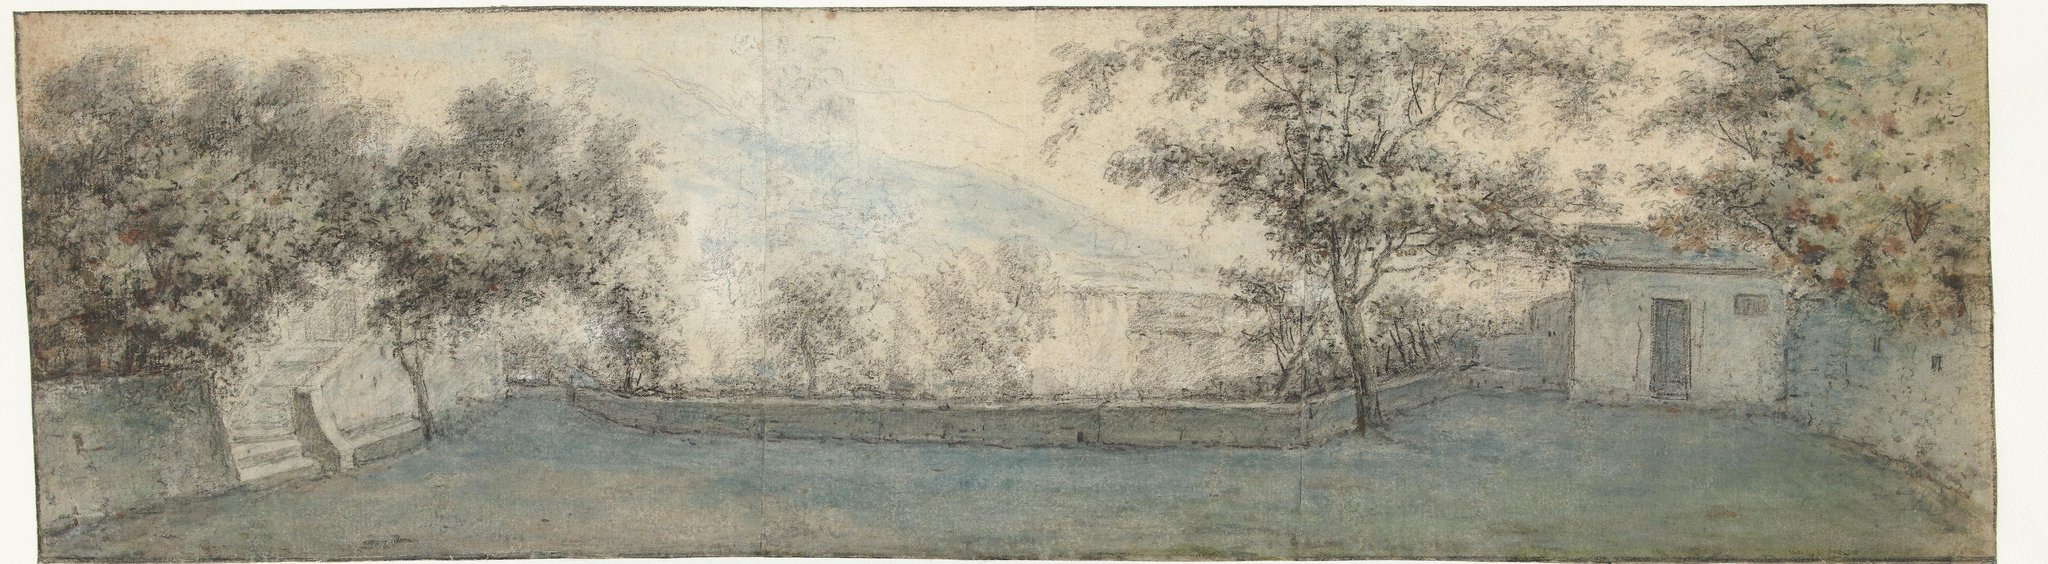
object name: drawing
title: Gezicht op een terras met links en rechts een paviljoen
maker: pierre adrien pâris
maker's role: draughtsman, print maker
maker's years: 1745-1819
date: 1755-1819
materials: chalk, paper, watercolor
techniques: brush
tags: garden, garden buildings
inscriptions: annotation, on a fragment of the old backing paper, pencil: ‘Collection R. Mouilleron’